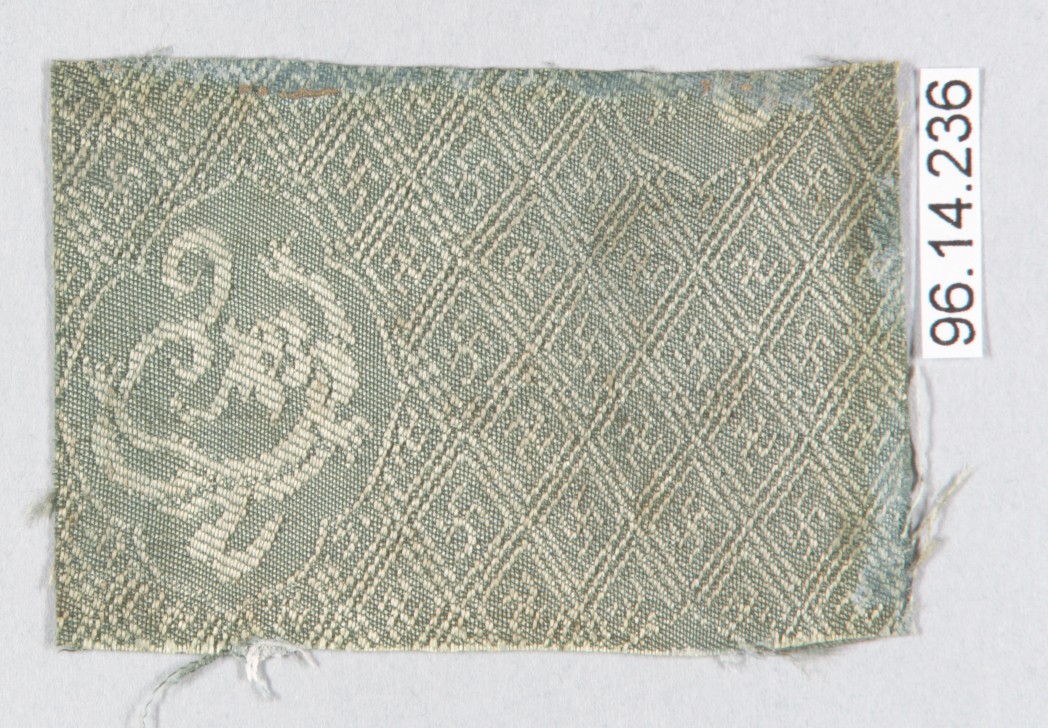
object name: piece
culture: japanese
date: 1701-1900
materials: silk